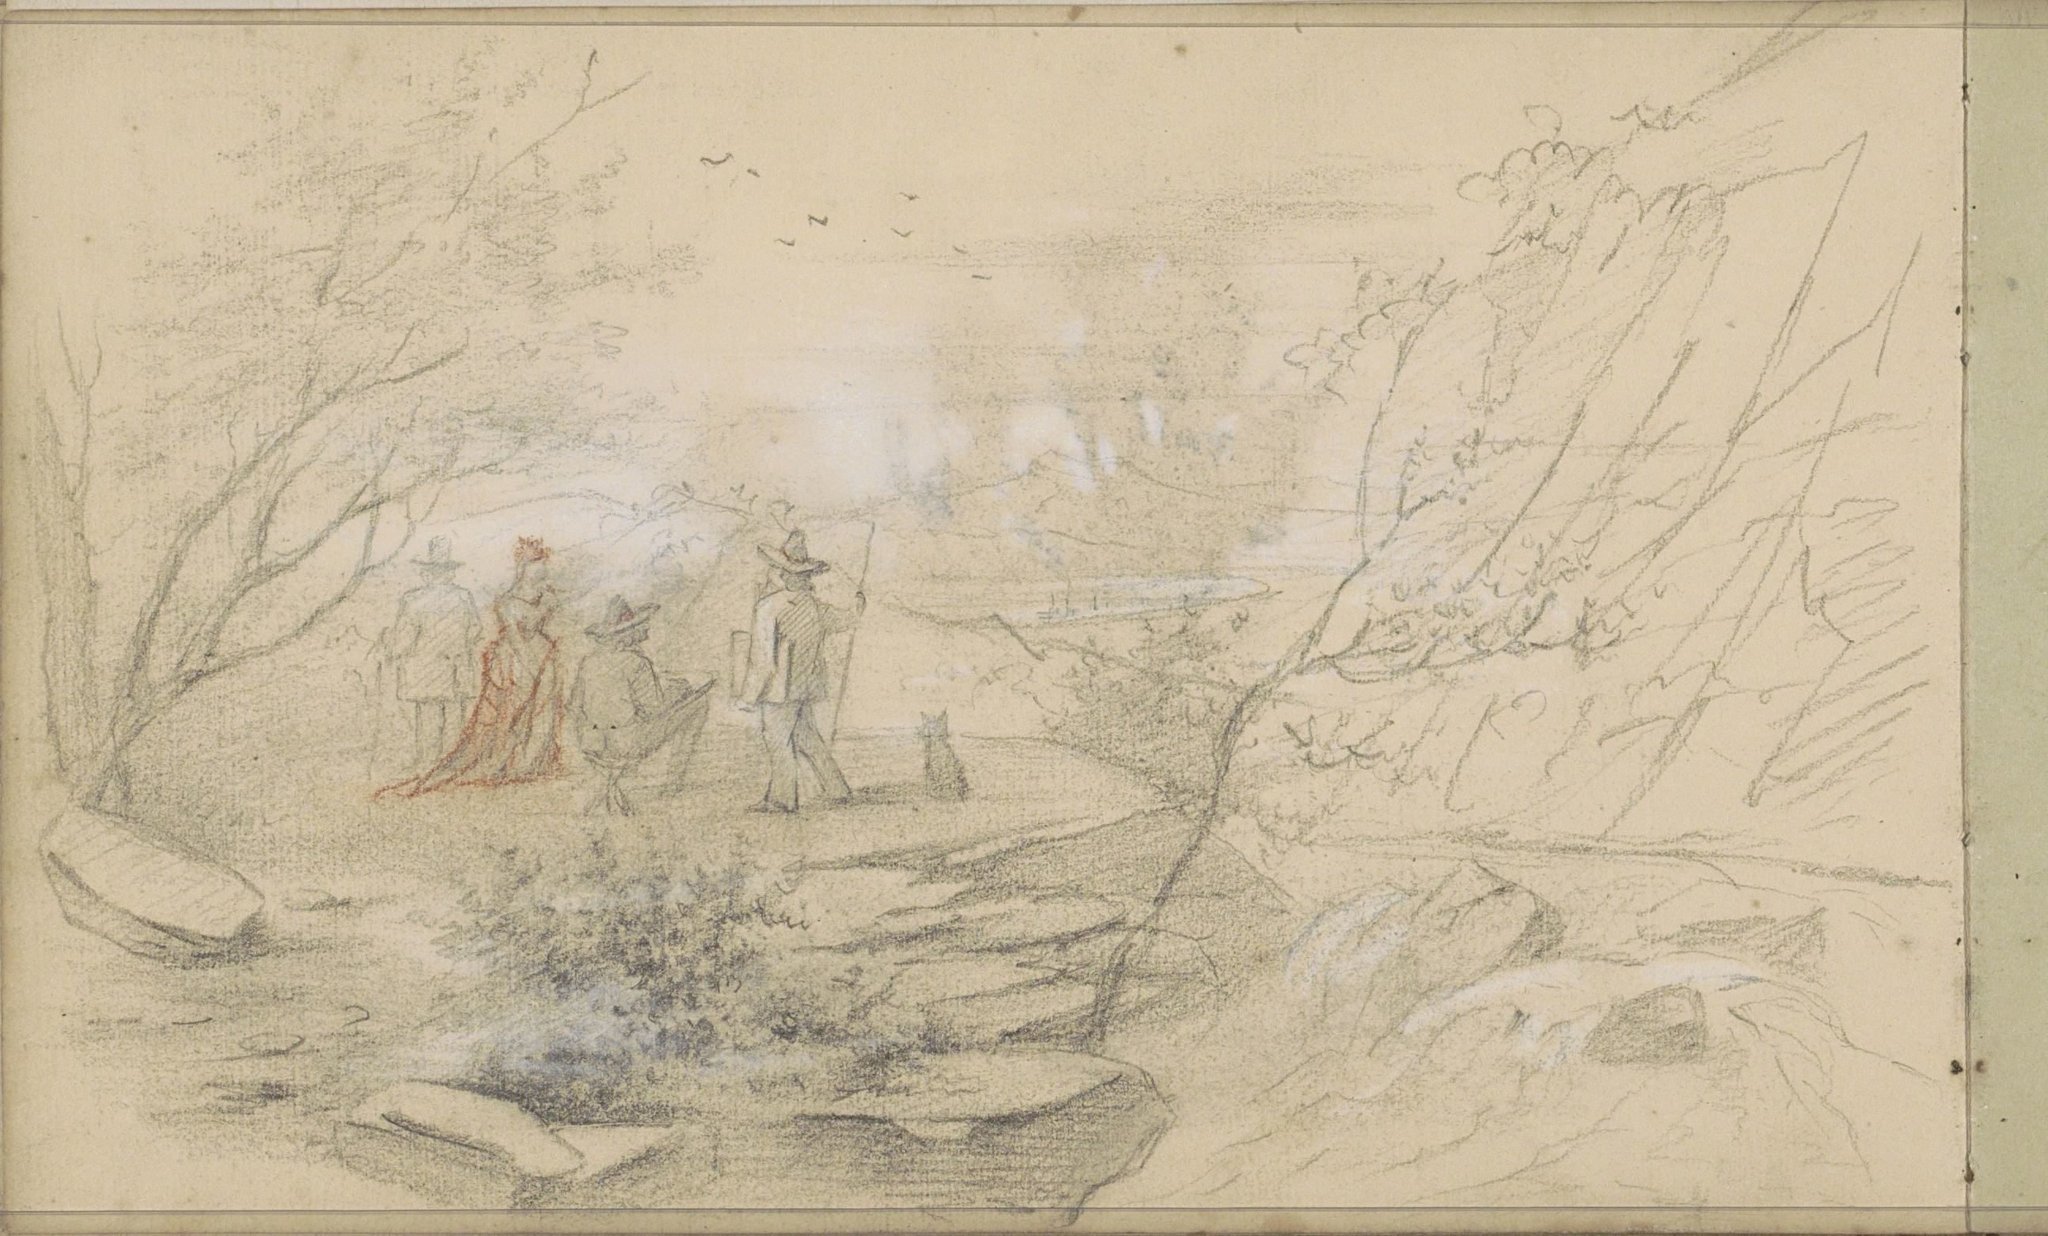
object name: sketchbook leaf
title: Figuren op een rotsachtige verhoging bij een beek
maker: willem cornelis rip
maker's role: draughtsman, painter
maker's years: 1856-1922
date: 1874-1875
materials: chalk, paper, pencil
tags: brook, rocks (+ landscape with figures, staffage)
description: Eén van de figuren draagt een tekenmap onder de arm. Een ander zit op een driepoot en heeft vermoedelijk een tekenblad op schoot. Naast de figuren zit een hond. Blad 41 verso uit een schetsboek met 46 bladen.